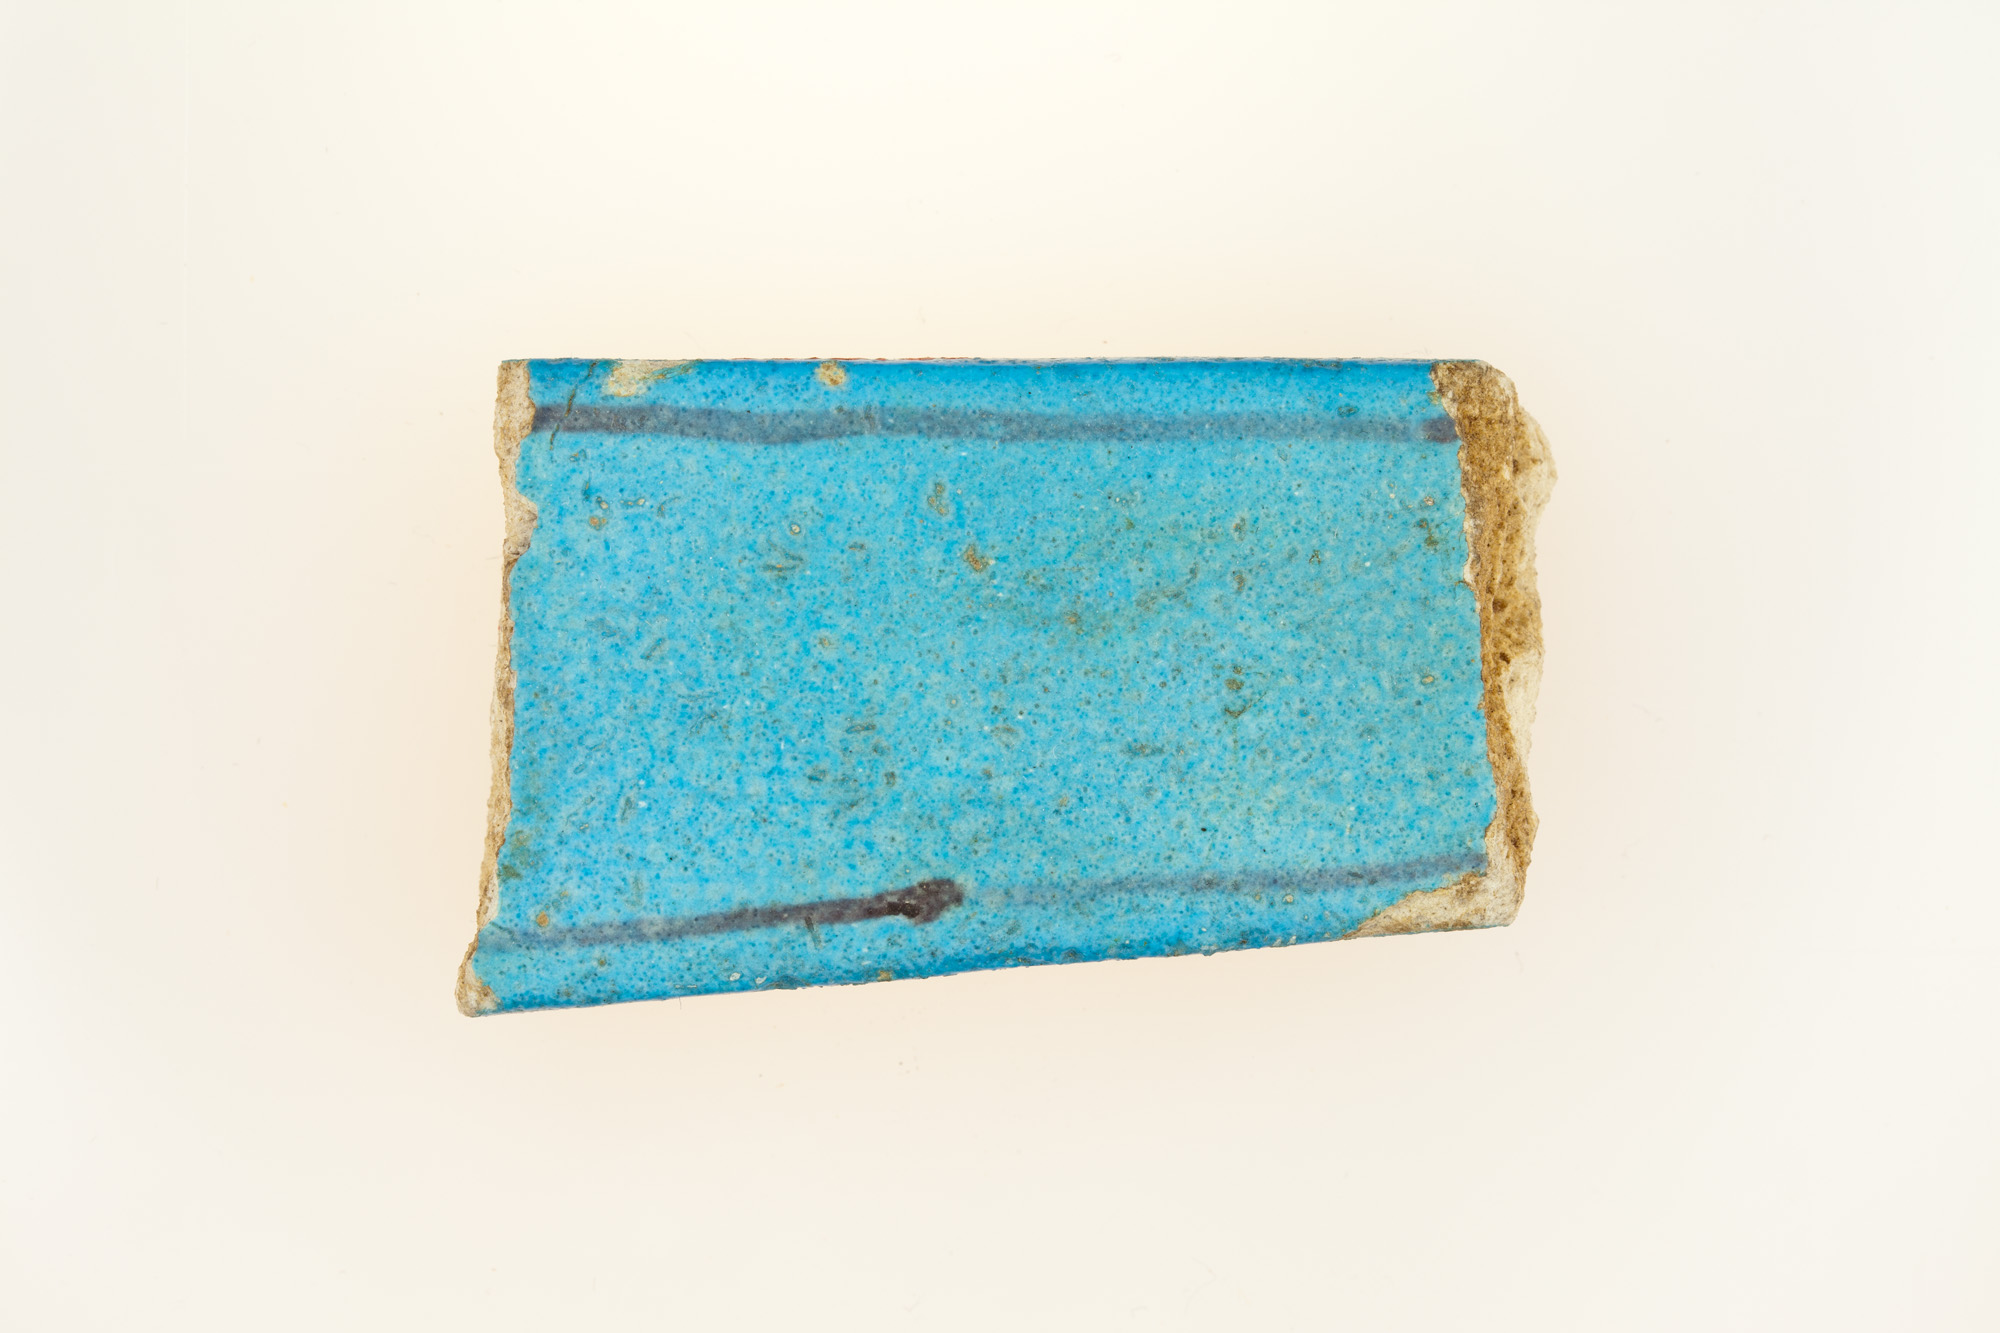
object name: menat fragment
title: Votive Menat fragments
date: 1479-1458 BCE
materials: faience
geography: egypt